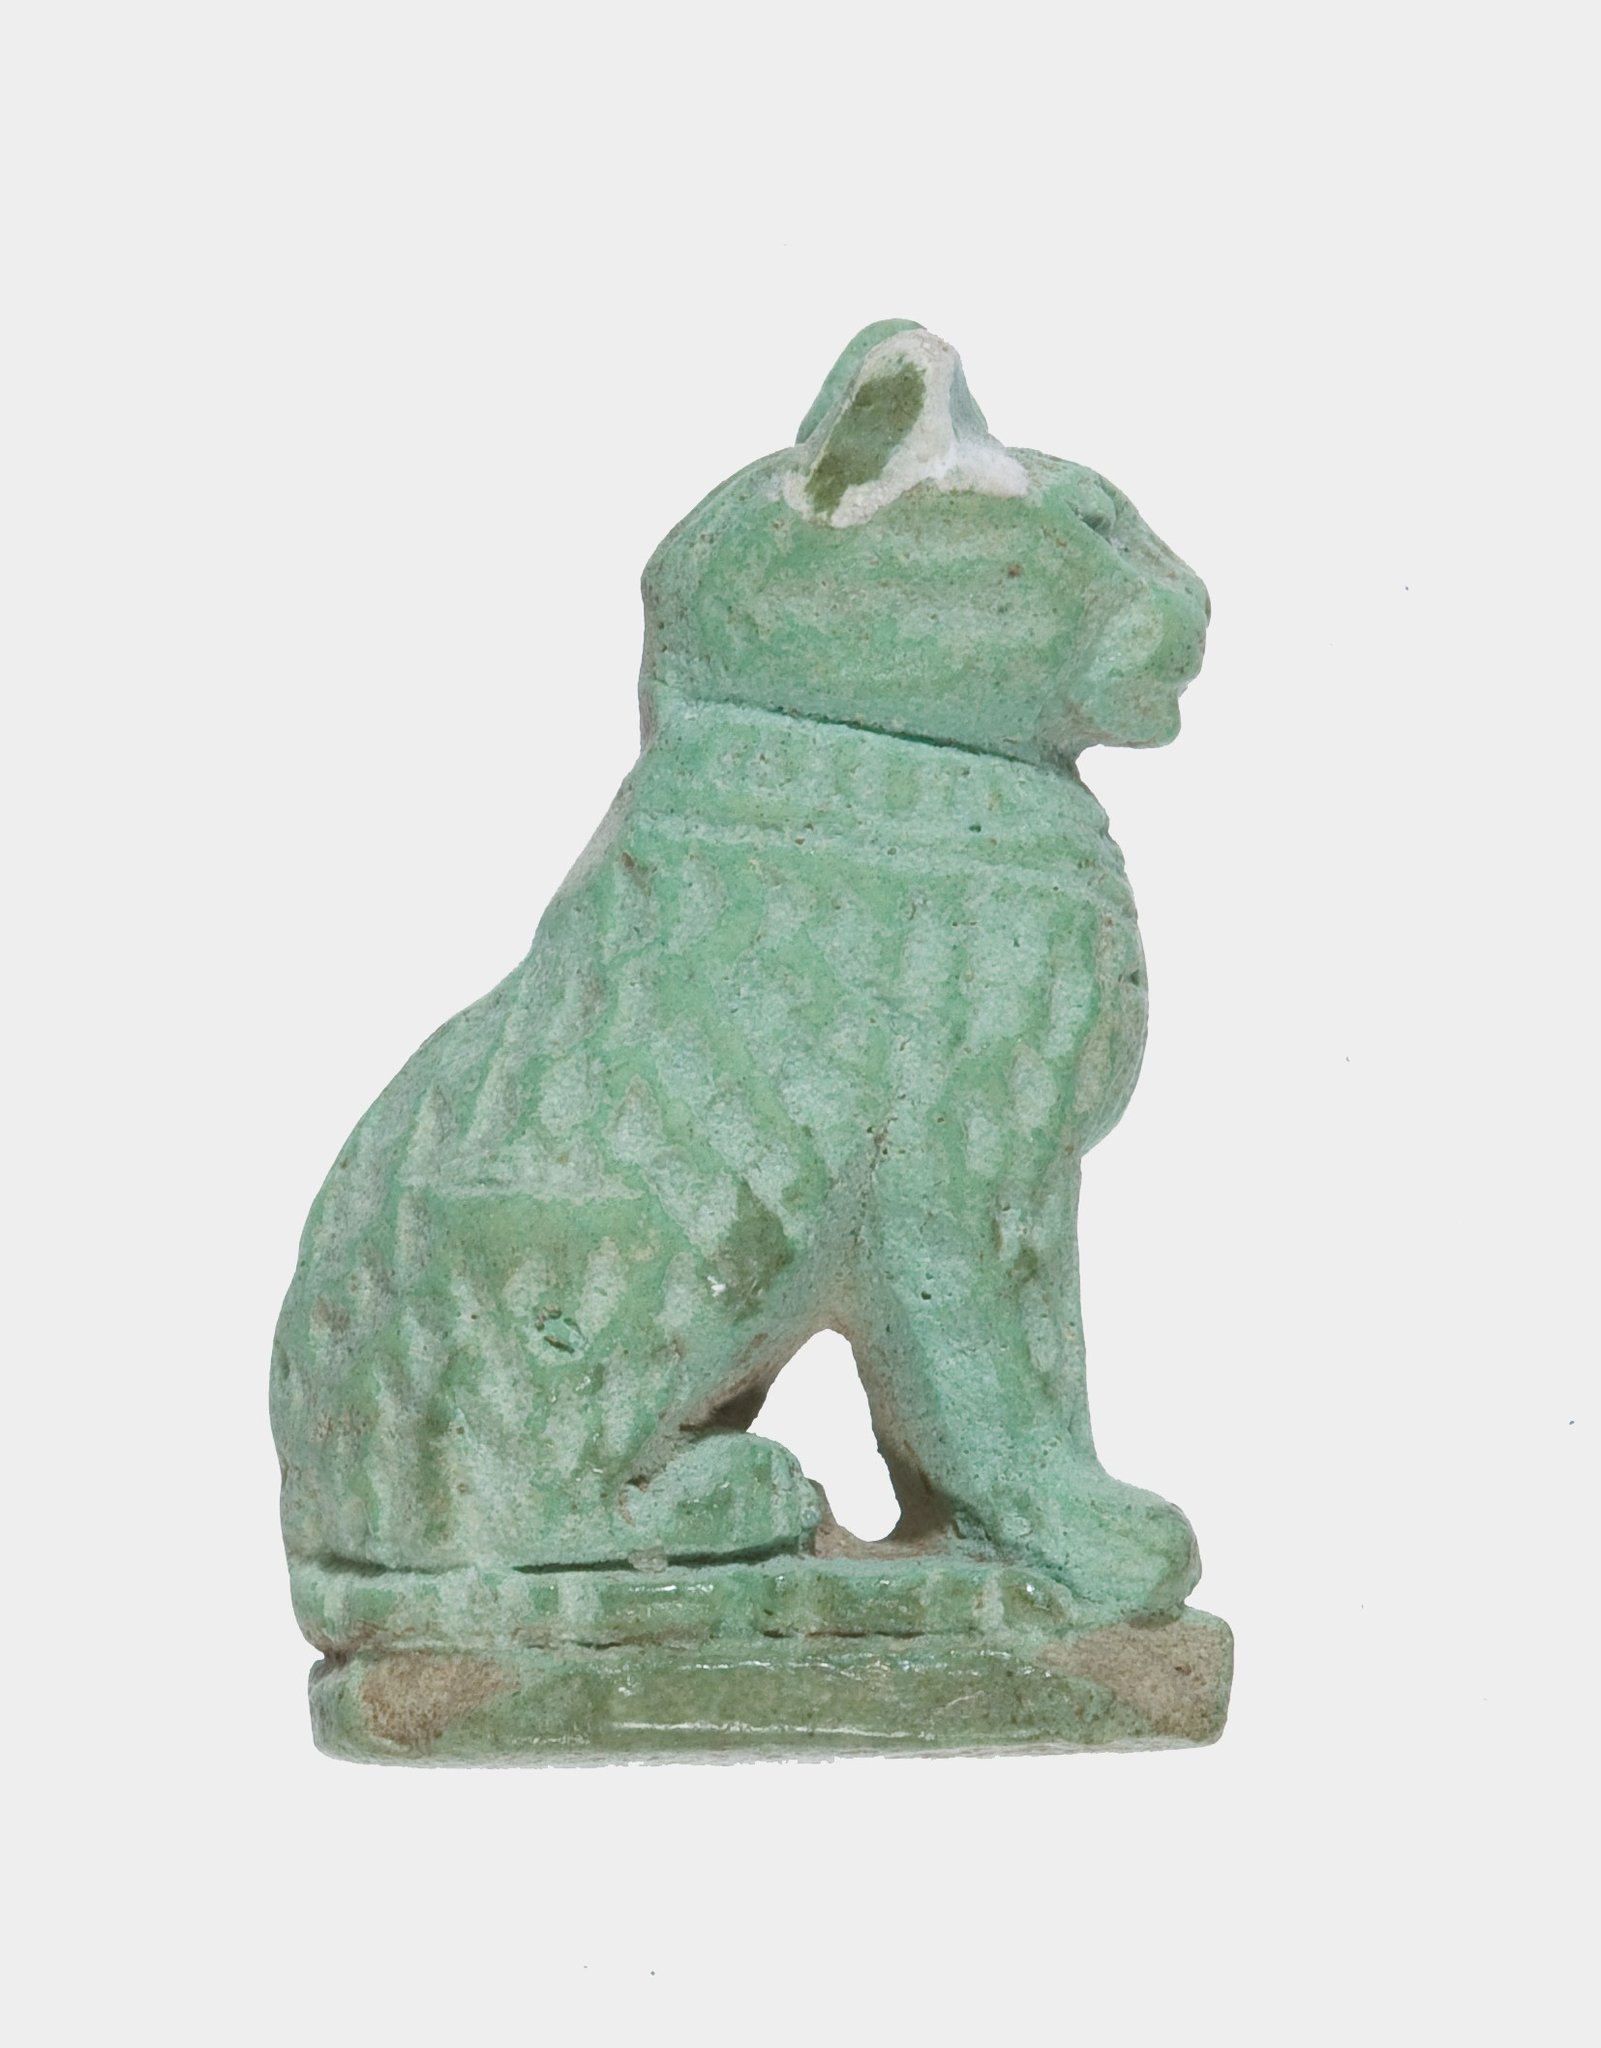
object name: amulet, cat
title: Cat amulet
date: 664-380 BCE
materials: faience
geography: egypt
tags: cats